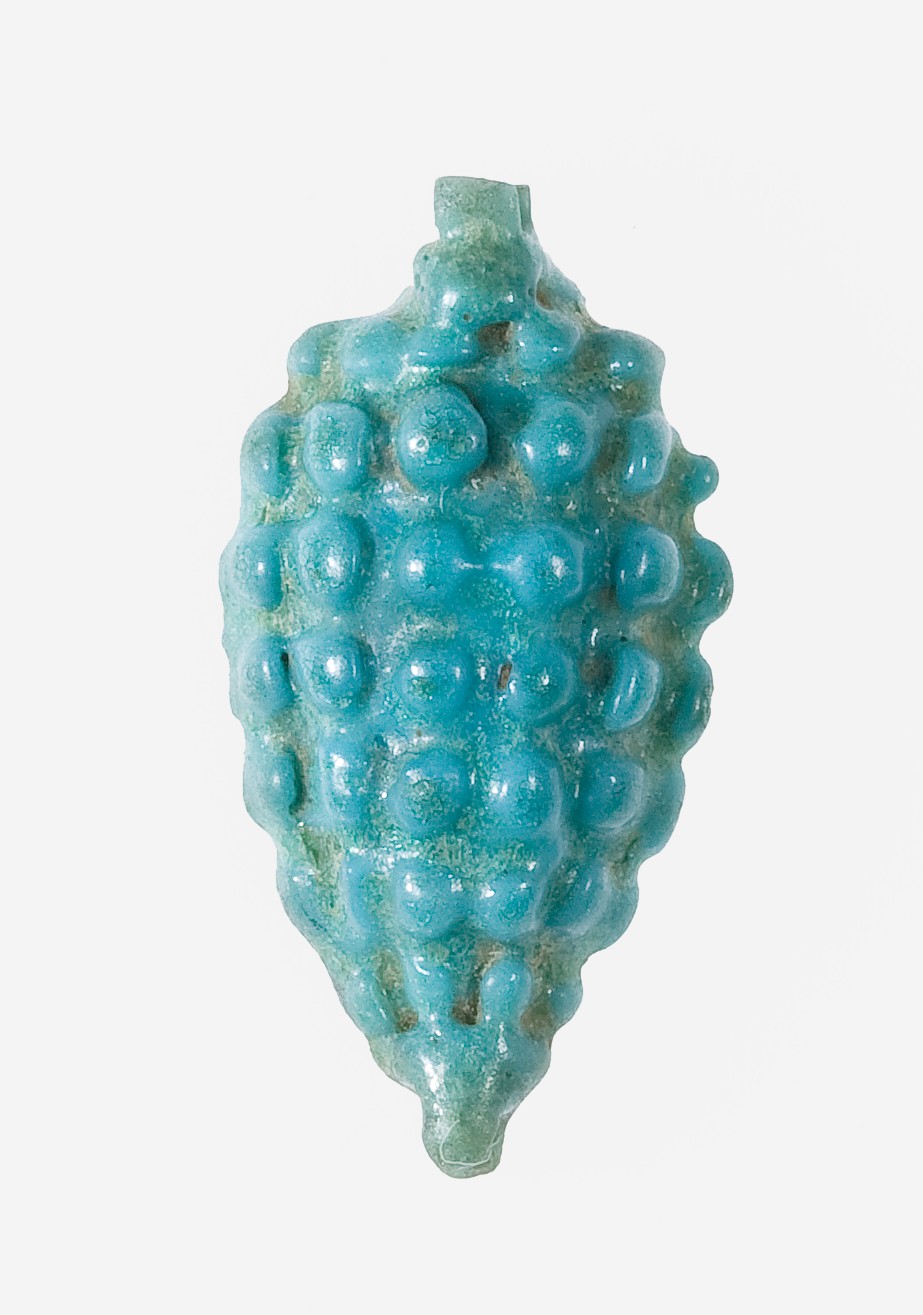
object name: bead, grape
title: Bead in the Form of a Bunch of Grapes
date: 1390-1352 BCE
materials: faience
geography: egypt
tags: grapes